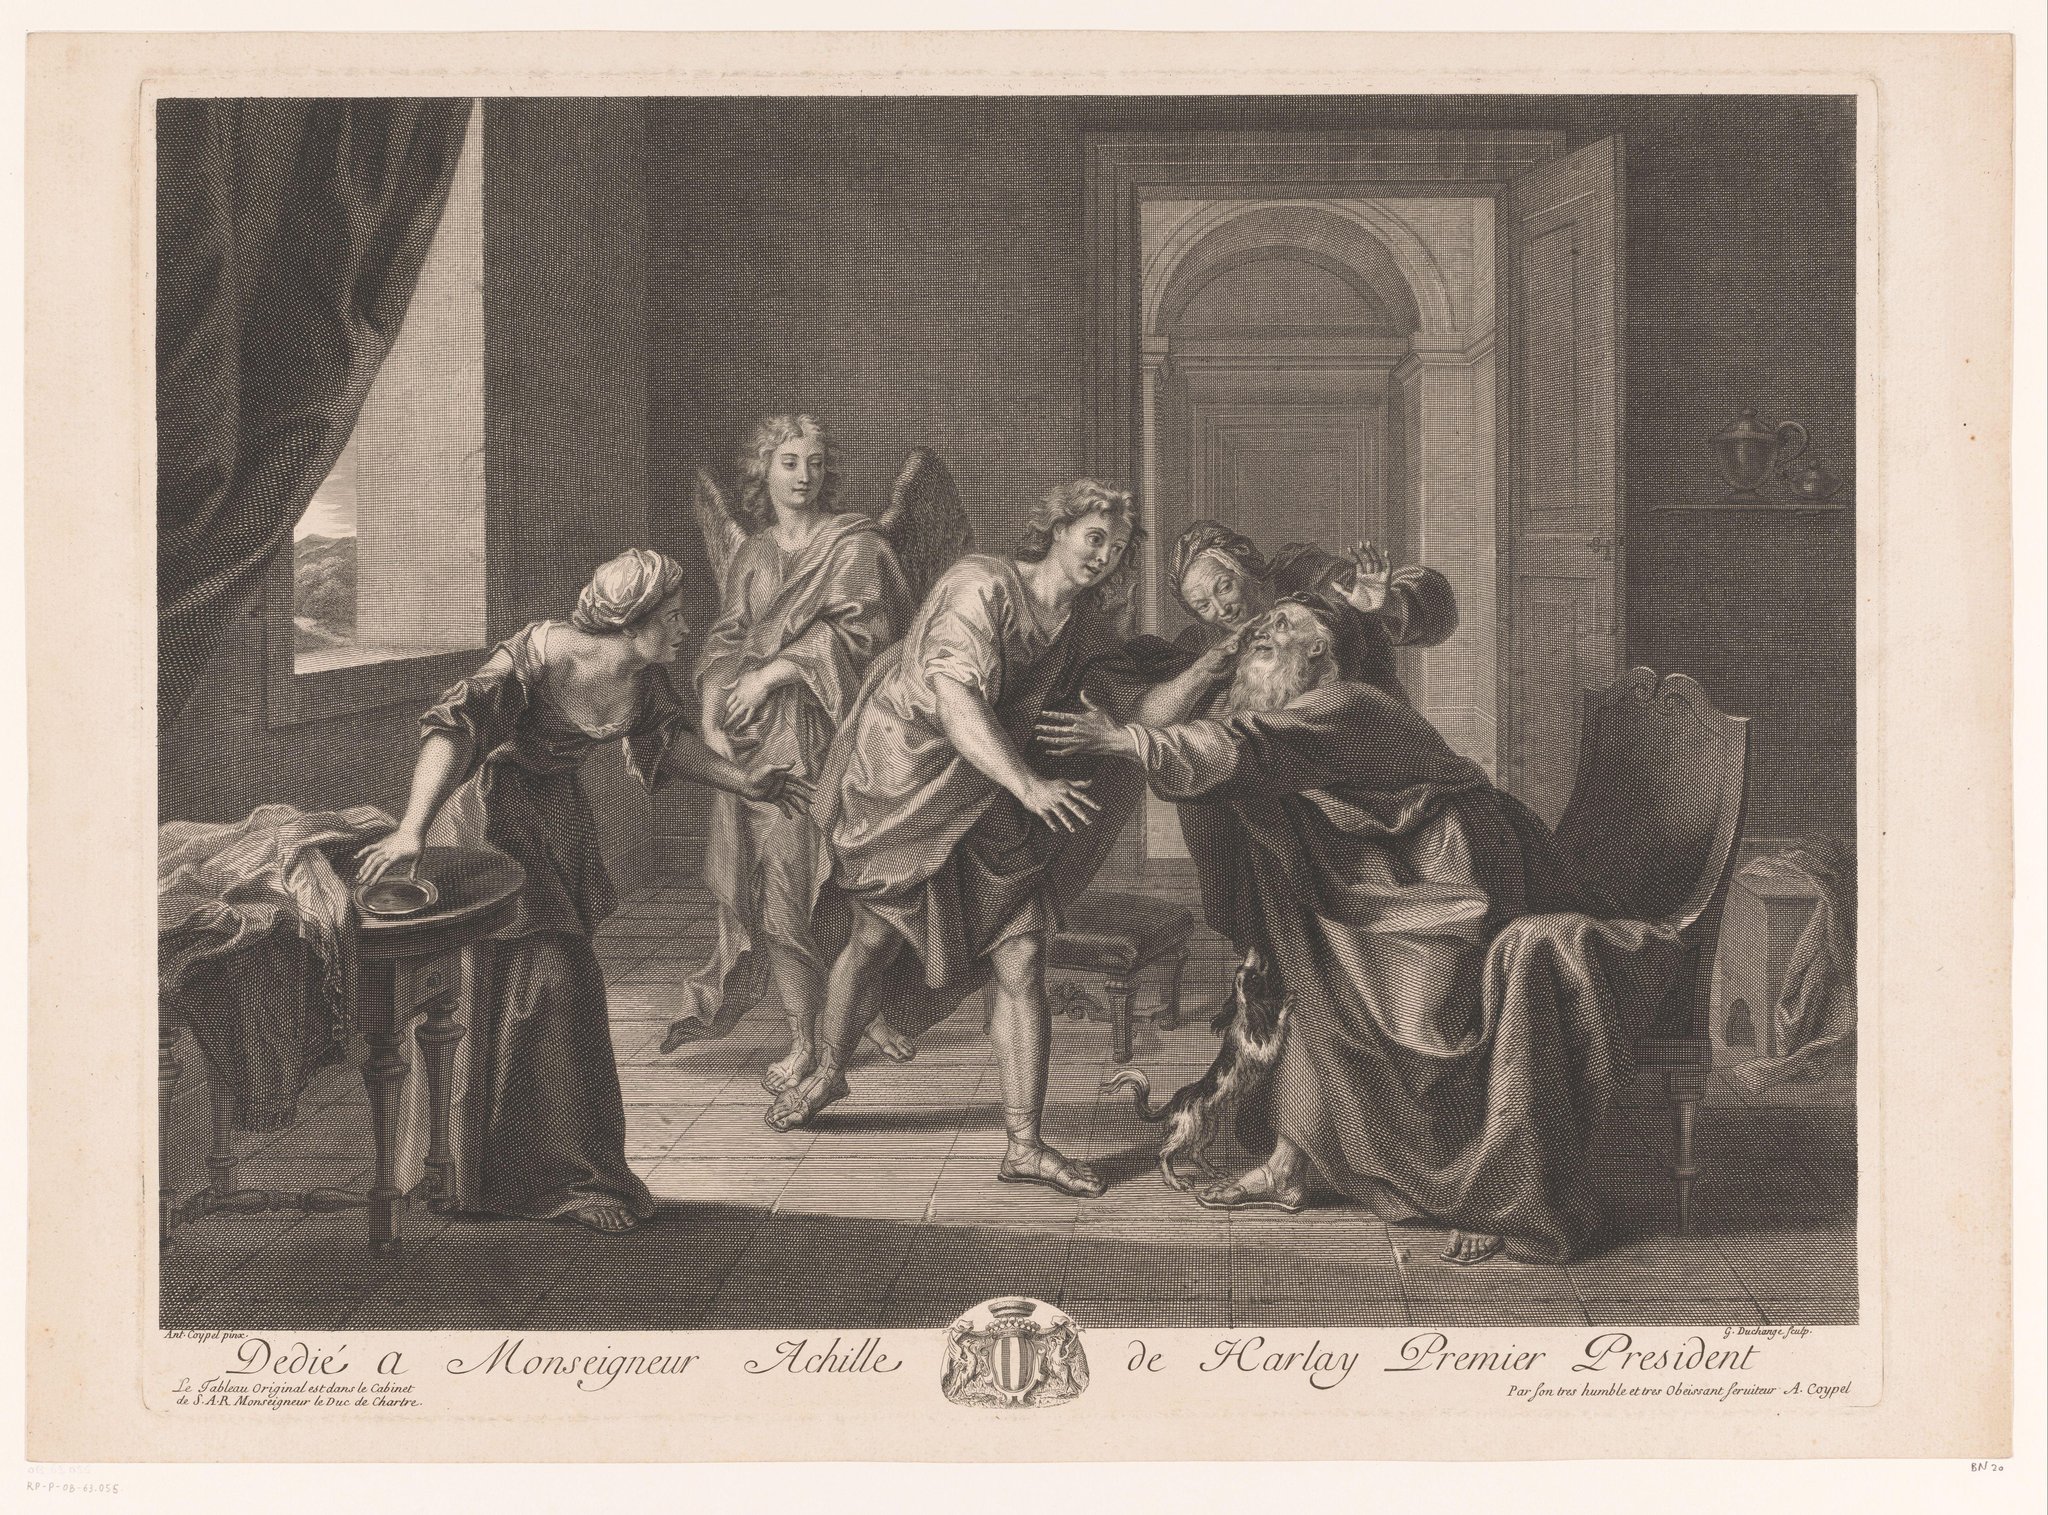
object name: print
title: Tobias maakt zijn vader weer ziende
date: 1699-1712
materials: paper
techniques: engraving, etching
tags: tobit's blindness (tobit 2 - 3:6)